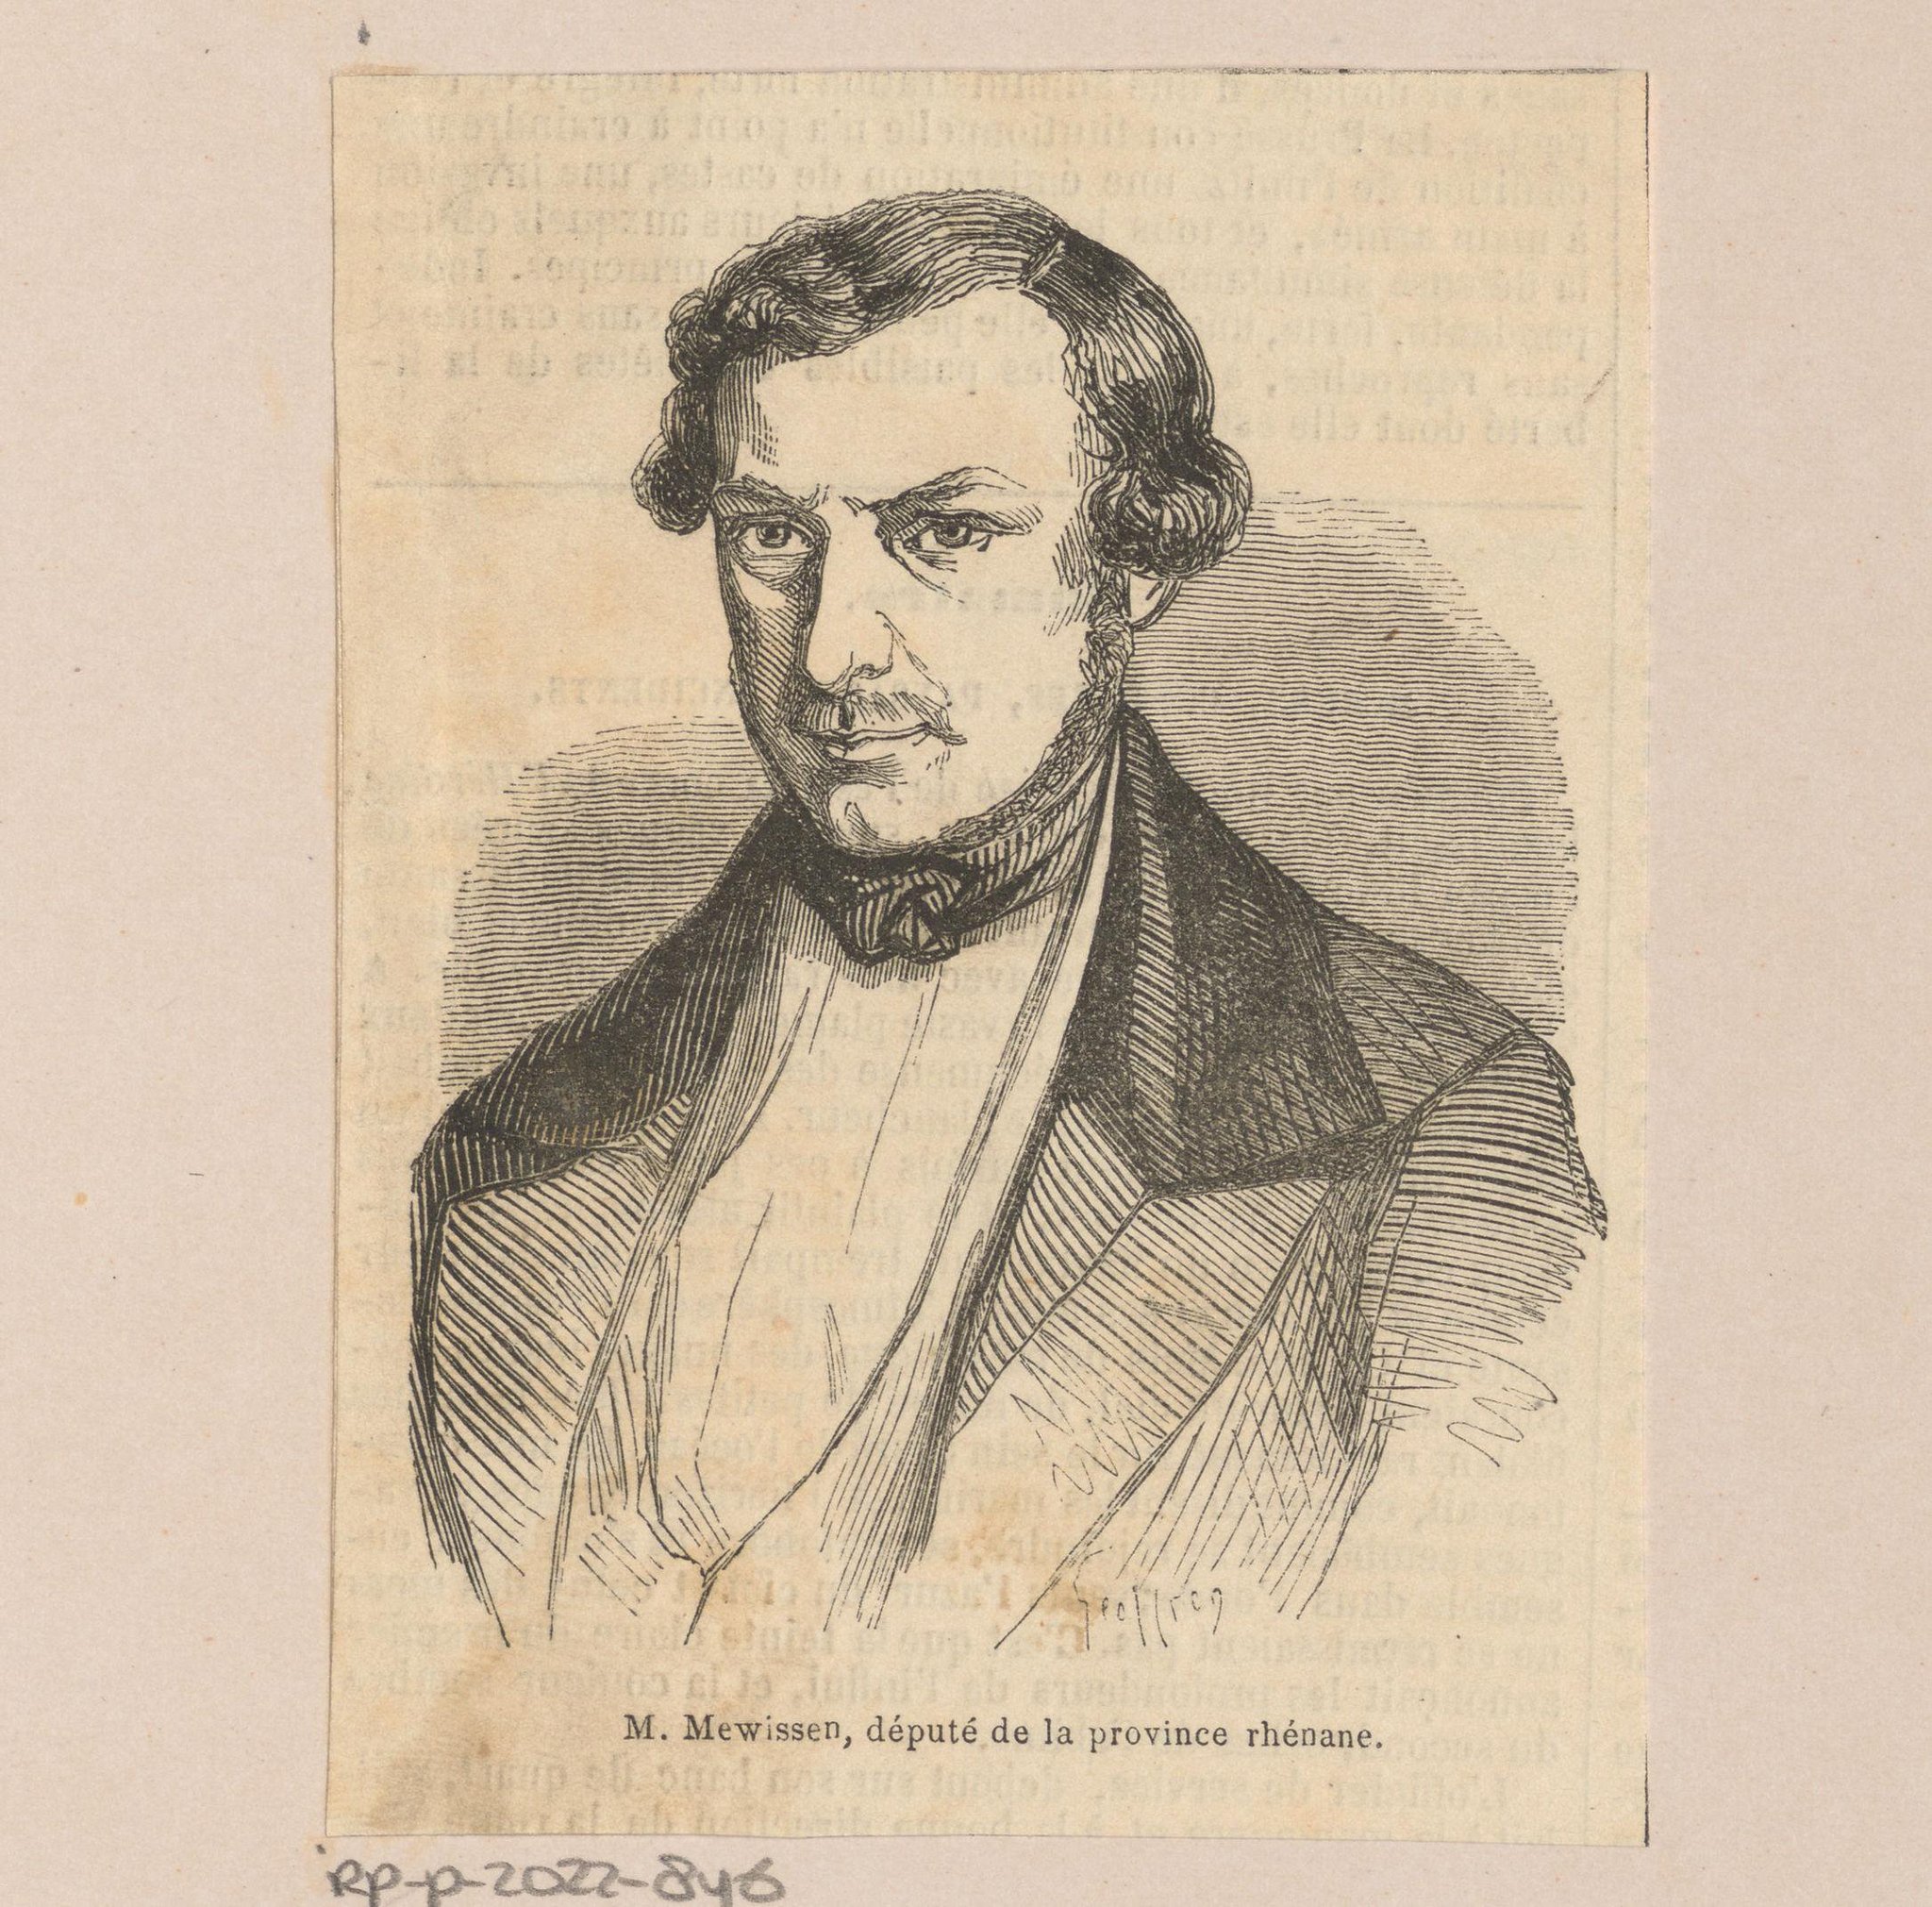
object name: photomechanical print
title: Portret van Gustav von Mevissen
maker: Anonymous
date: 1847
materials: paper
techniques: letterpress printing, line block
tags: adult man, historical persons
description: Cliché uit: L'Illustration Journal Universel 224 (1847), zaterdag 12 juni 1847, dl. 9.